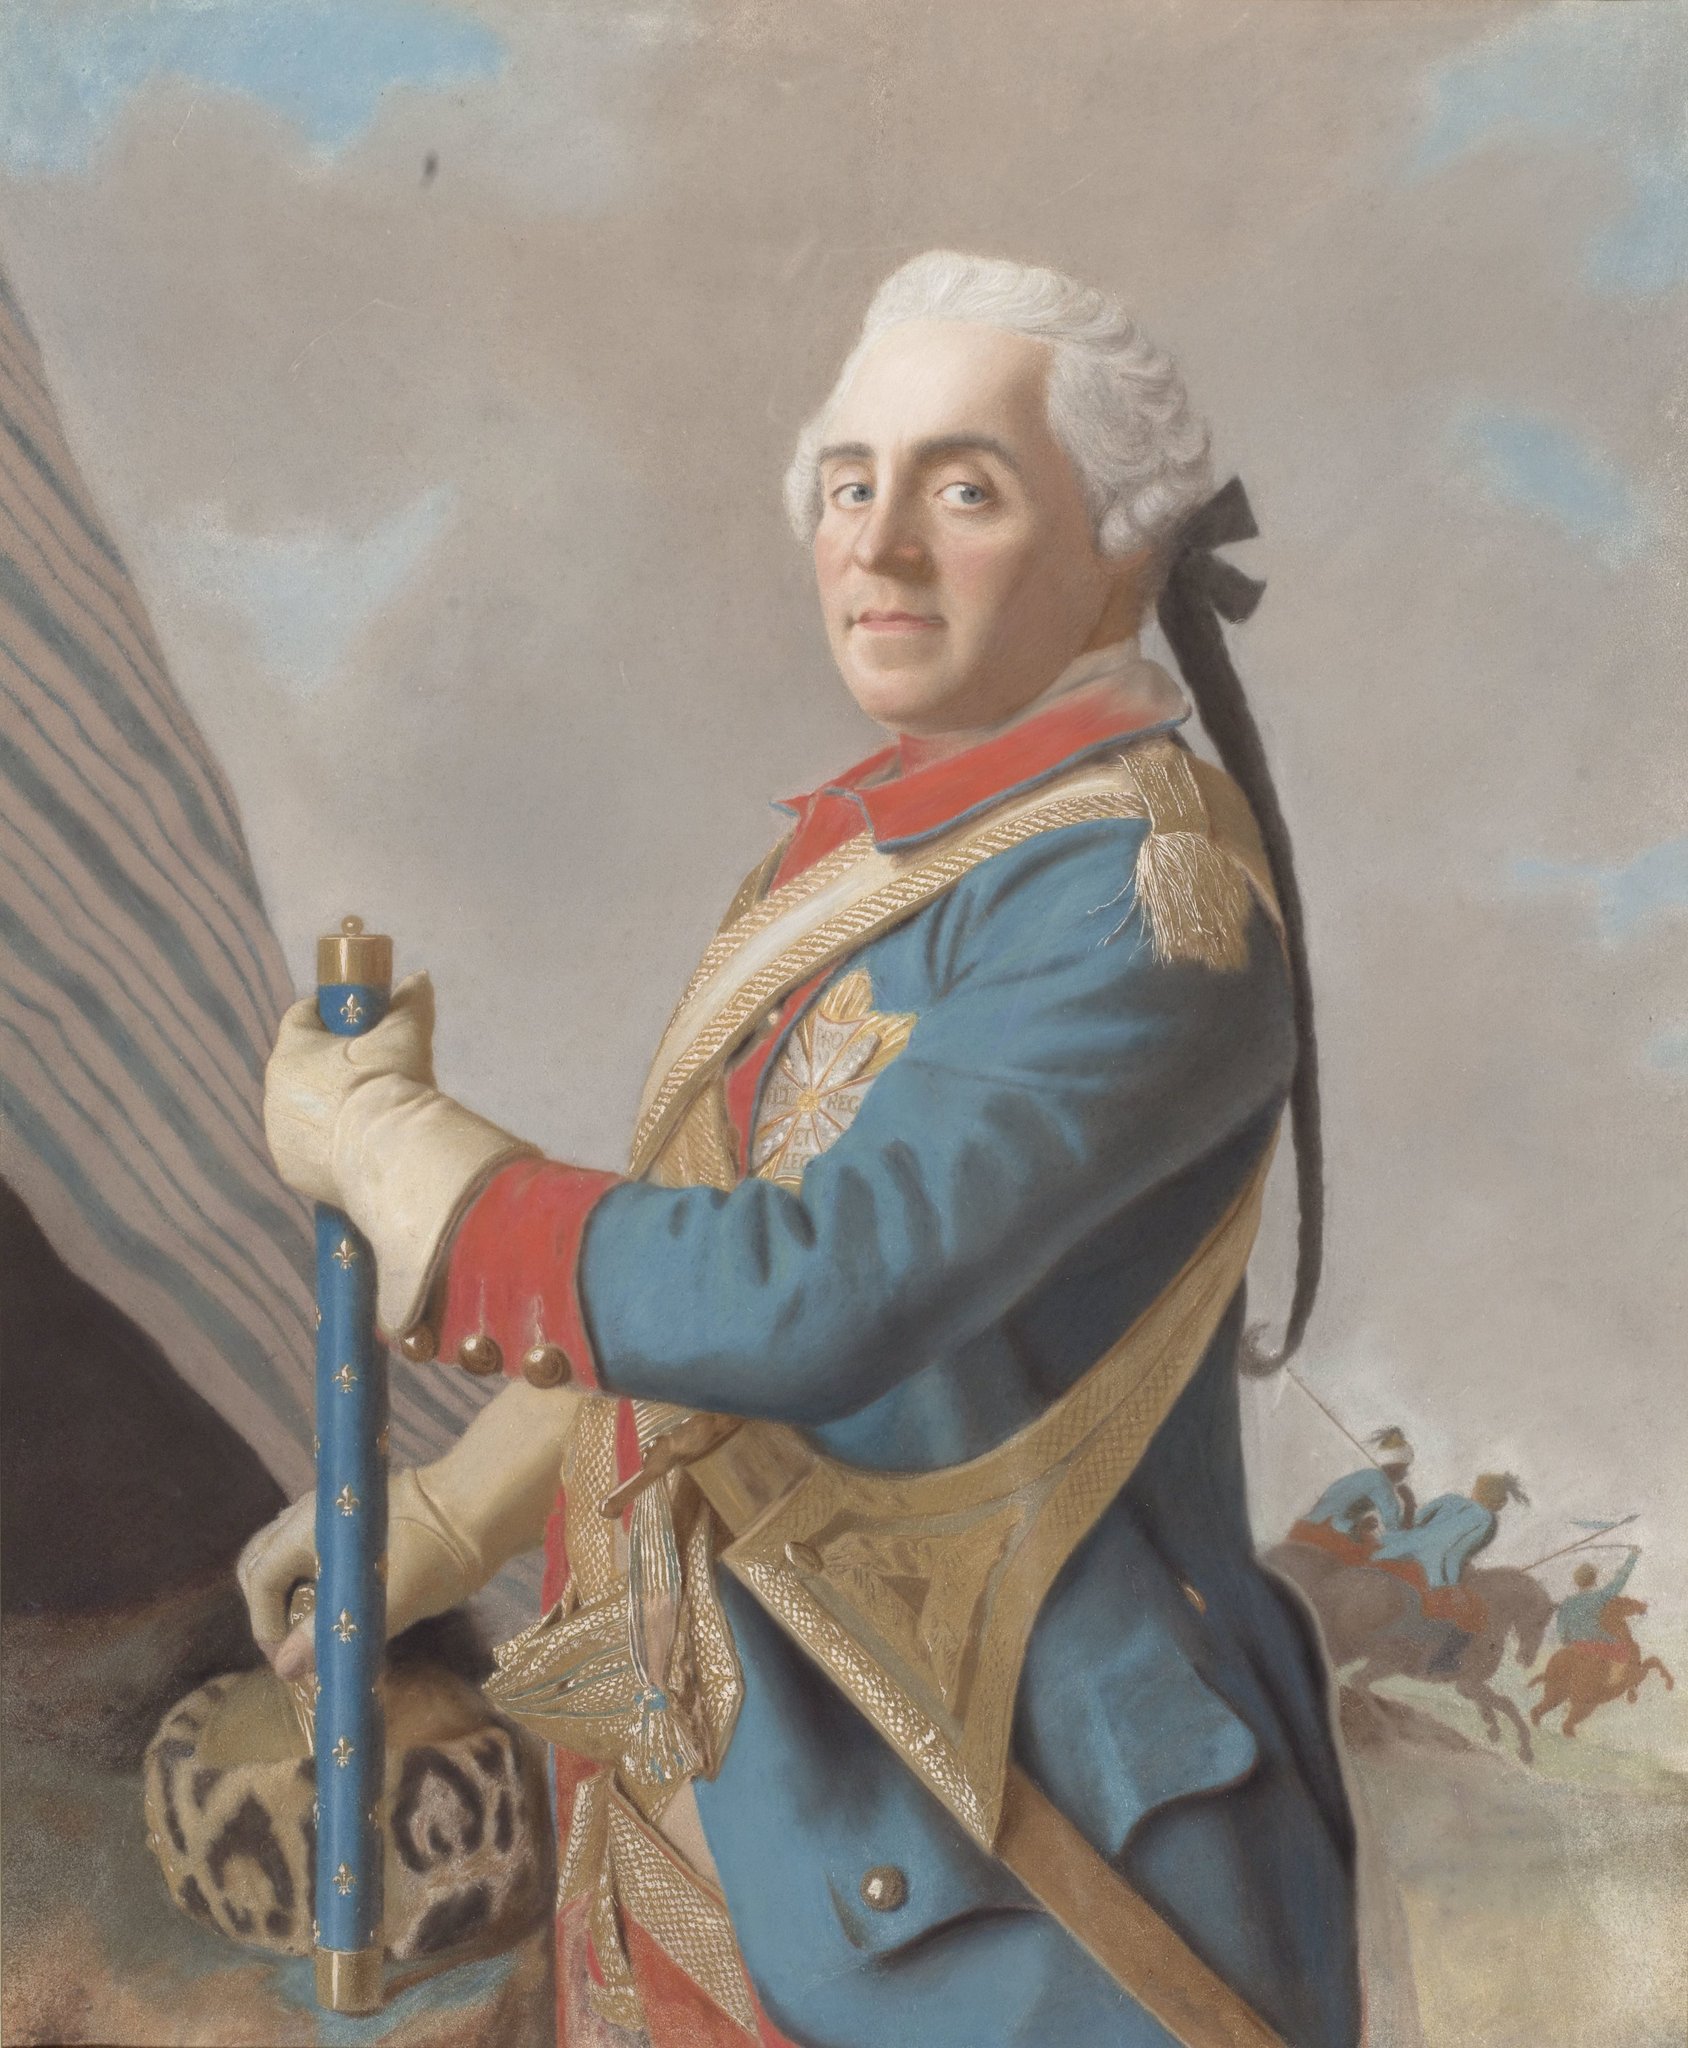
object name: drawing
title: Portret van Moritz, Graf von Sachsen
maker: jean-etienne liotard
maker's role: painter, print maker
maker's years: 1702-1789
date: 1748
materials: parchment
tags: moritz graf von sachsen, commander-in-chief, general, marshal, historical persons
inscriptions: inscription: ‘Le Maréchal de saxe inhumé à Strasbourg d'après nature par Liotard’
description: Jean-Etienne Liotard (1702 - 1789). Count Hermann Maurice de Saxe (1696 - 1750), Marshal of France. Miss M.A. Liotard bequest, Amsterdam, 1873.